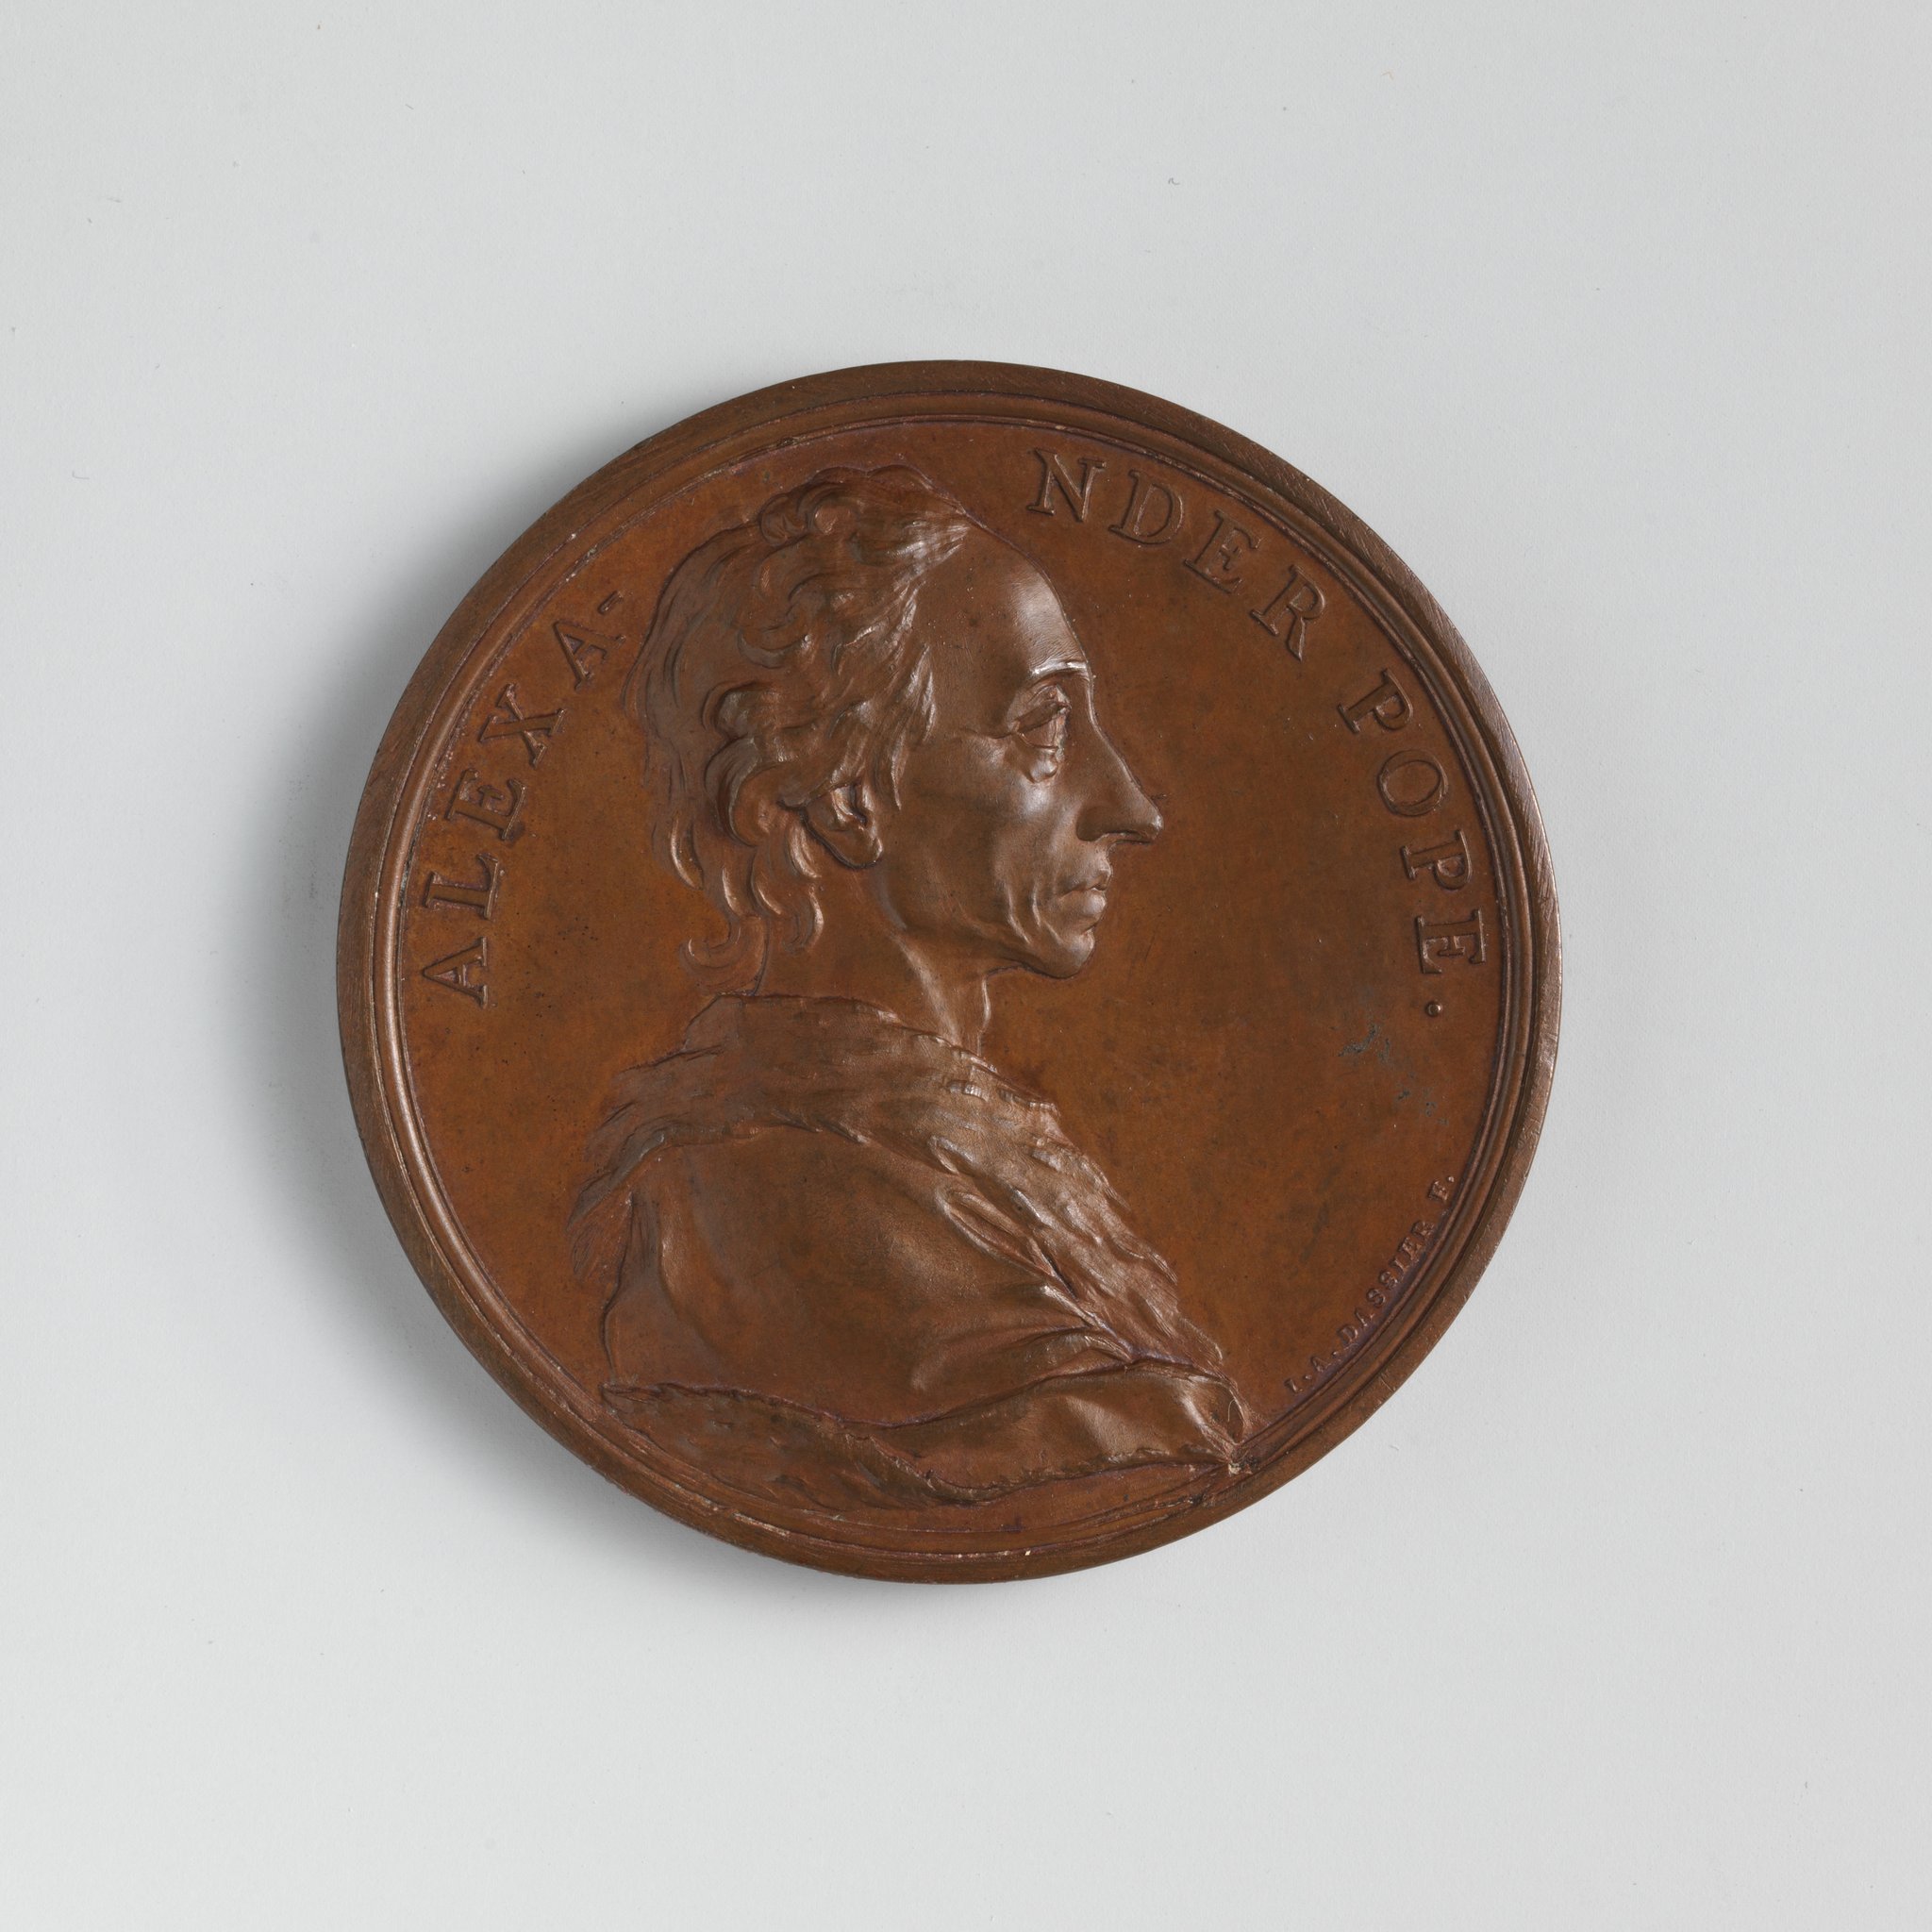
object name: medal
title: Alexander Pope (1688–1744)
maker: jacques-antoine dassier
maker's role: artist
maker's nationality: swiss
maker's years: 1715-1759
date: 1741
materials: bronze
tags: men,profiles